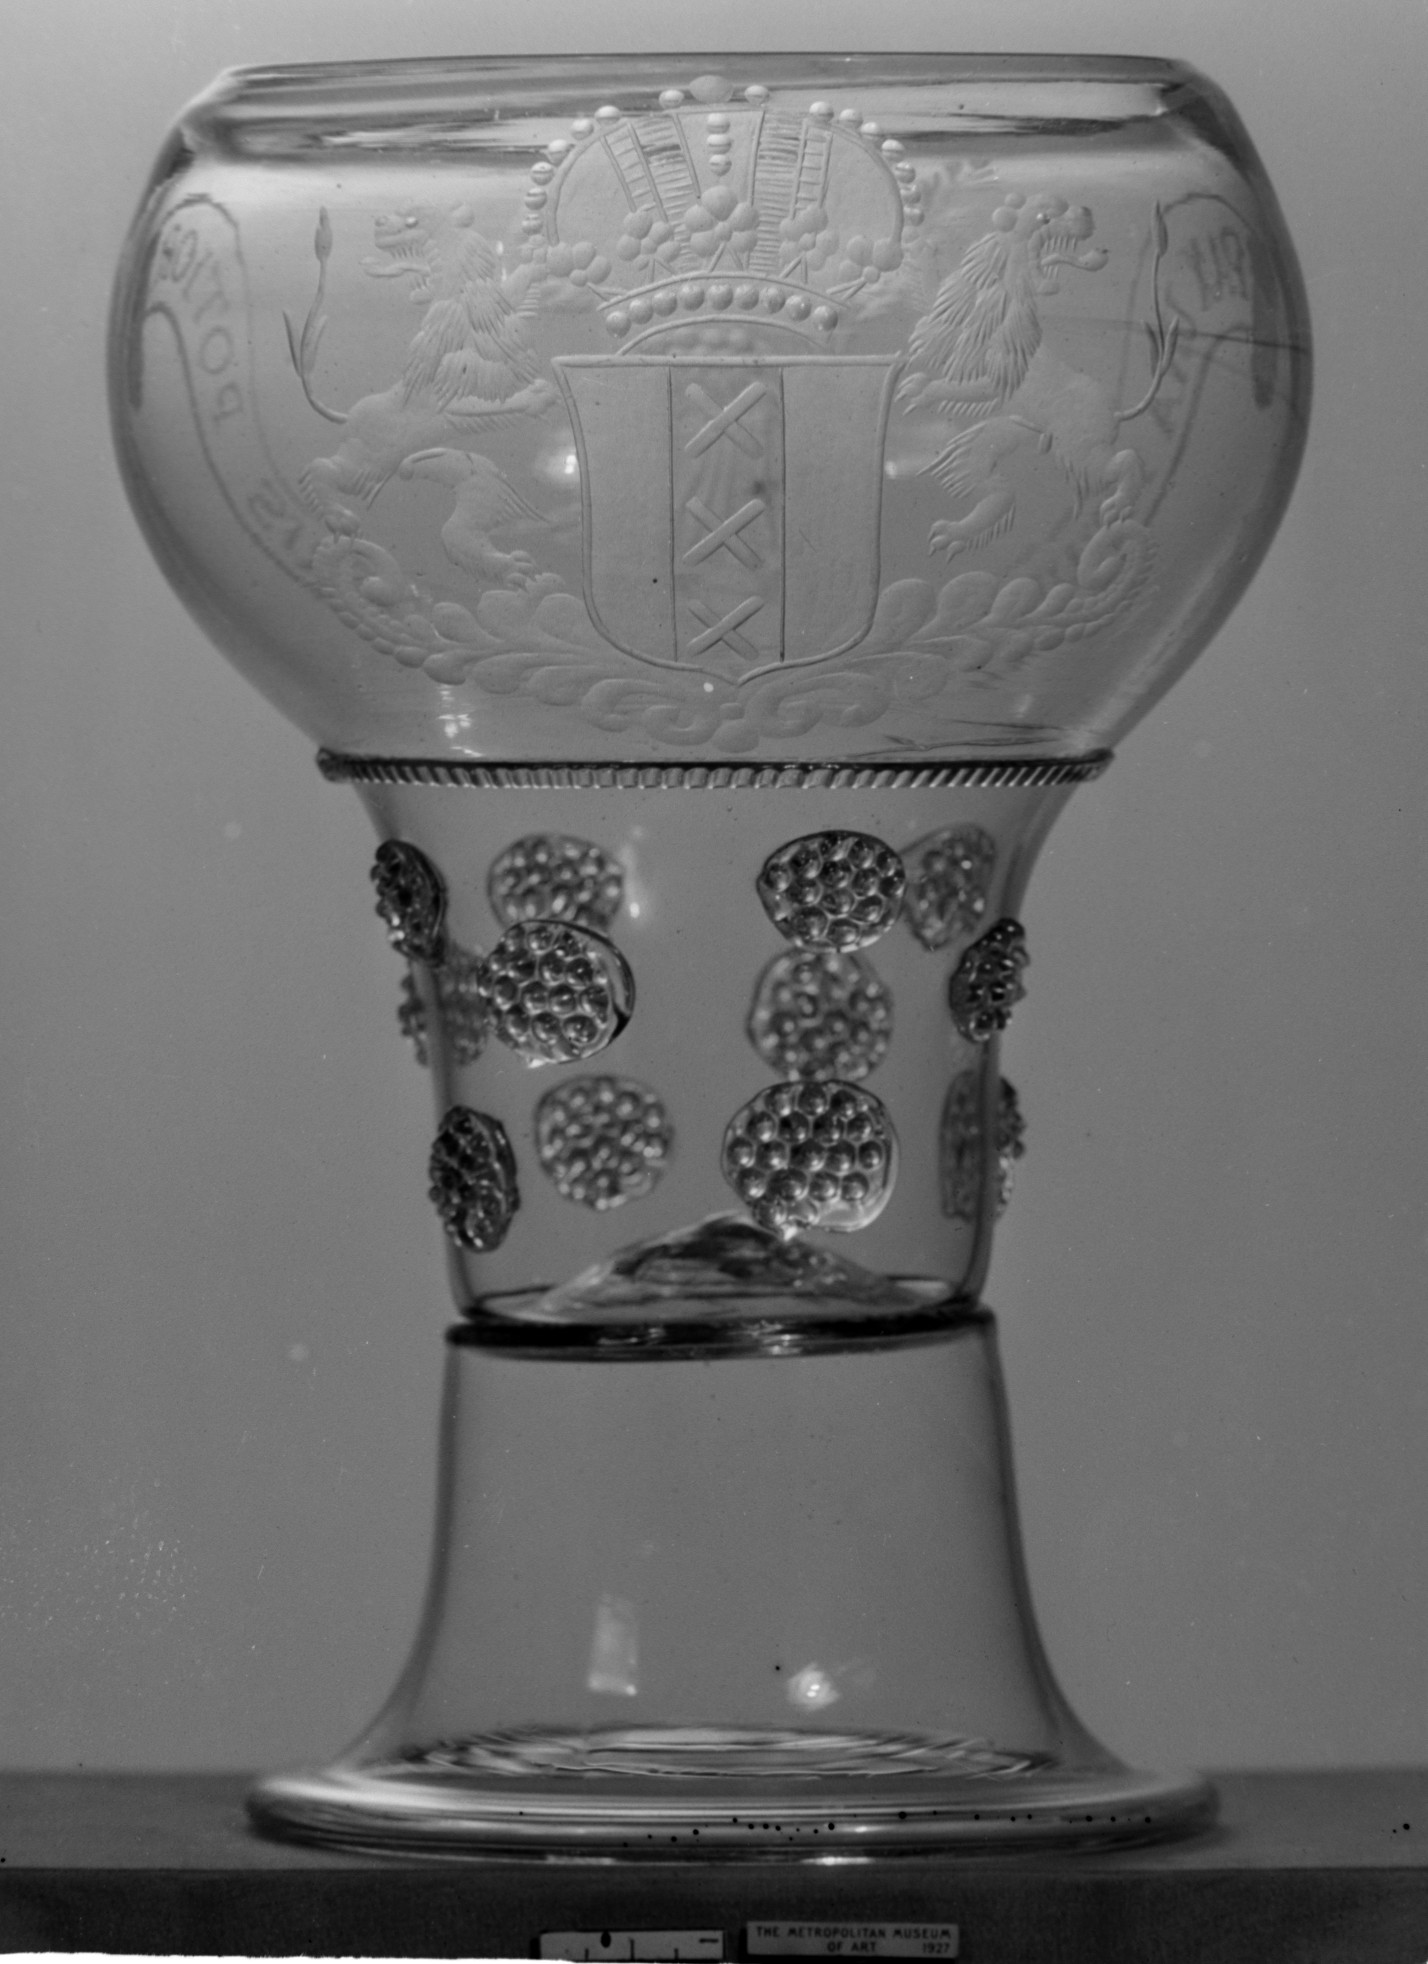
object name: goblet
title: Goblet (Roemer)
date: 1700-1750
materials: glass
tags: lions,coat of arms